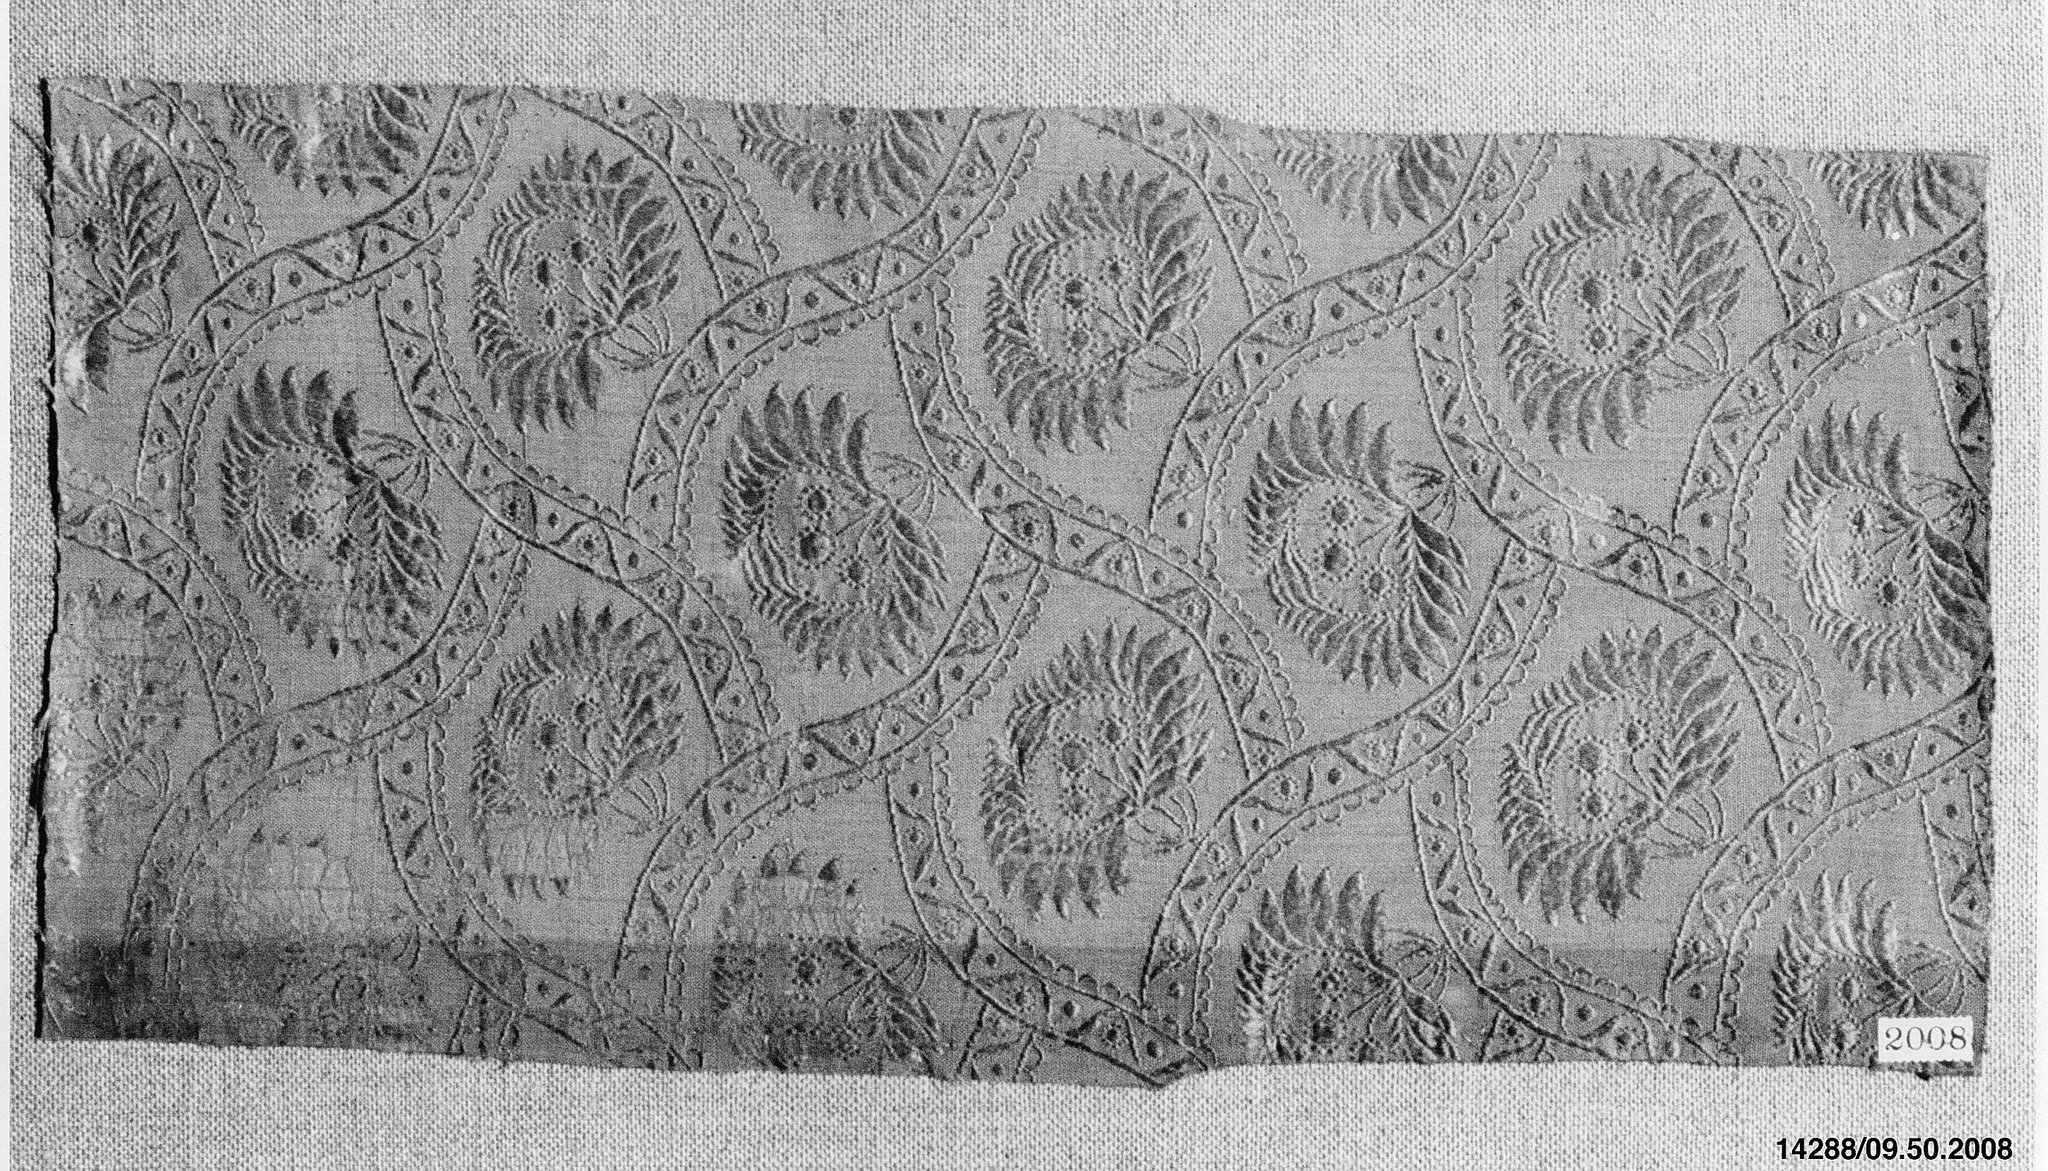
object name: piece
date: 1701-1800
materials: silk